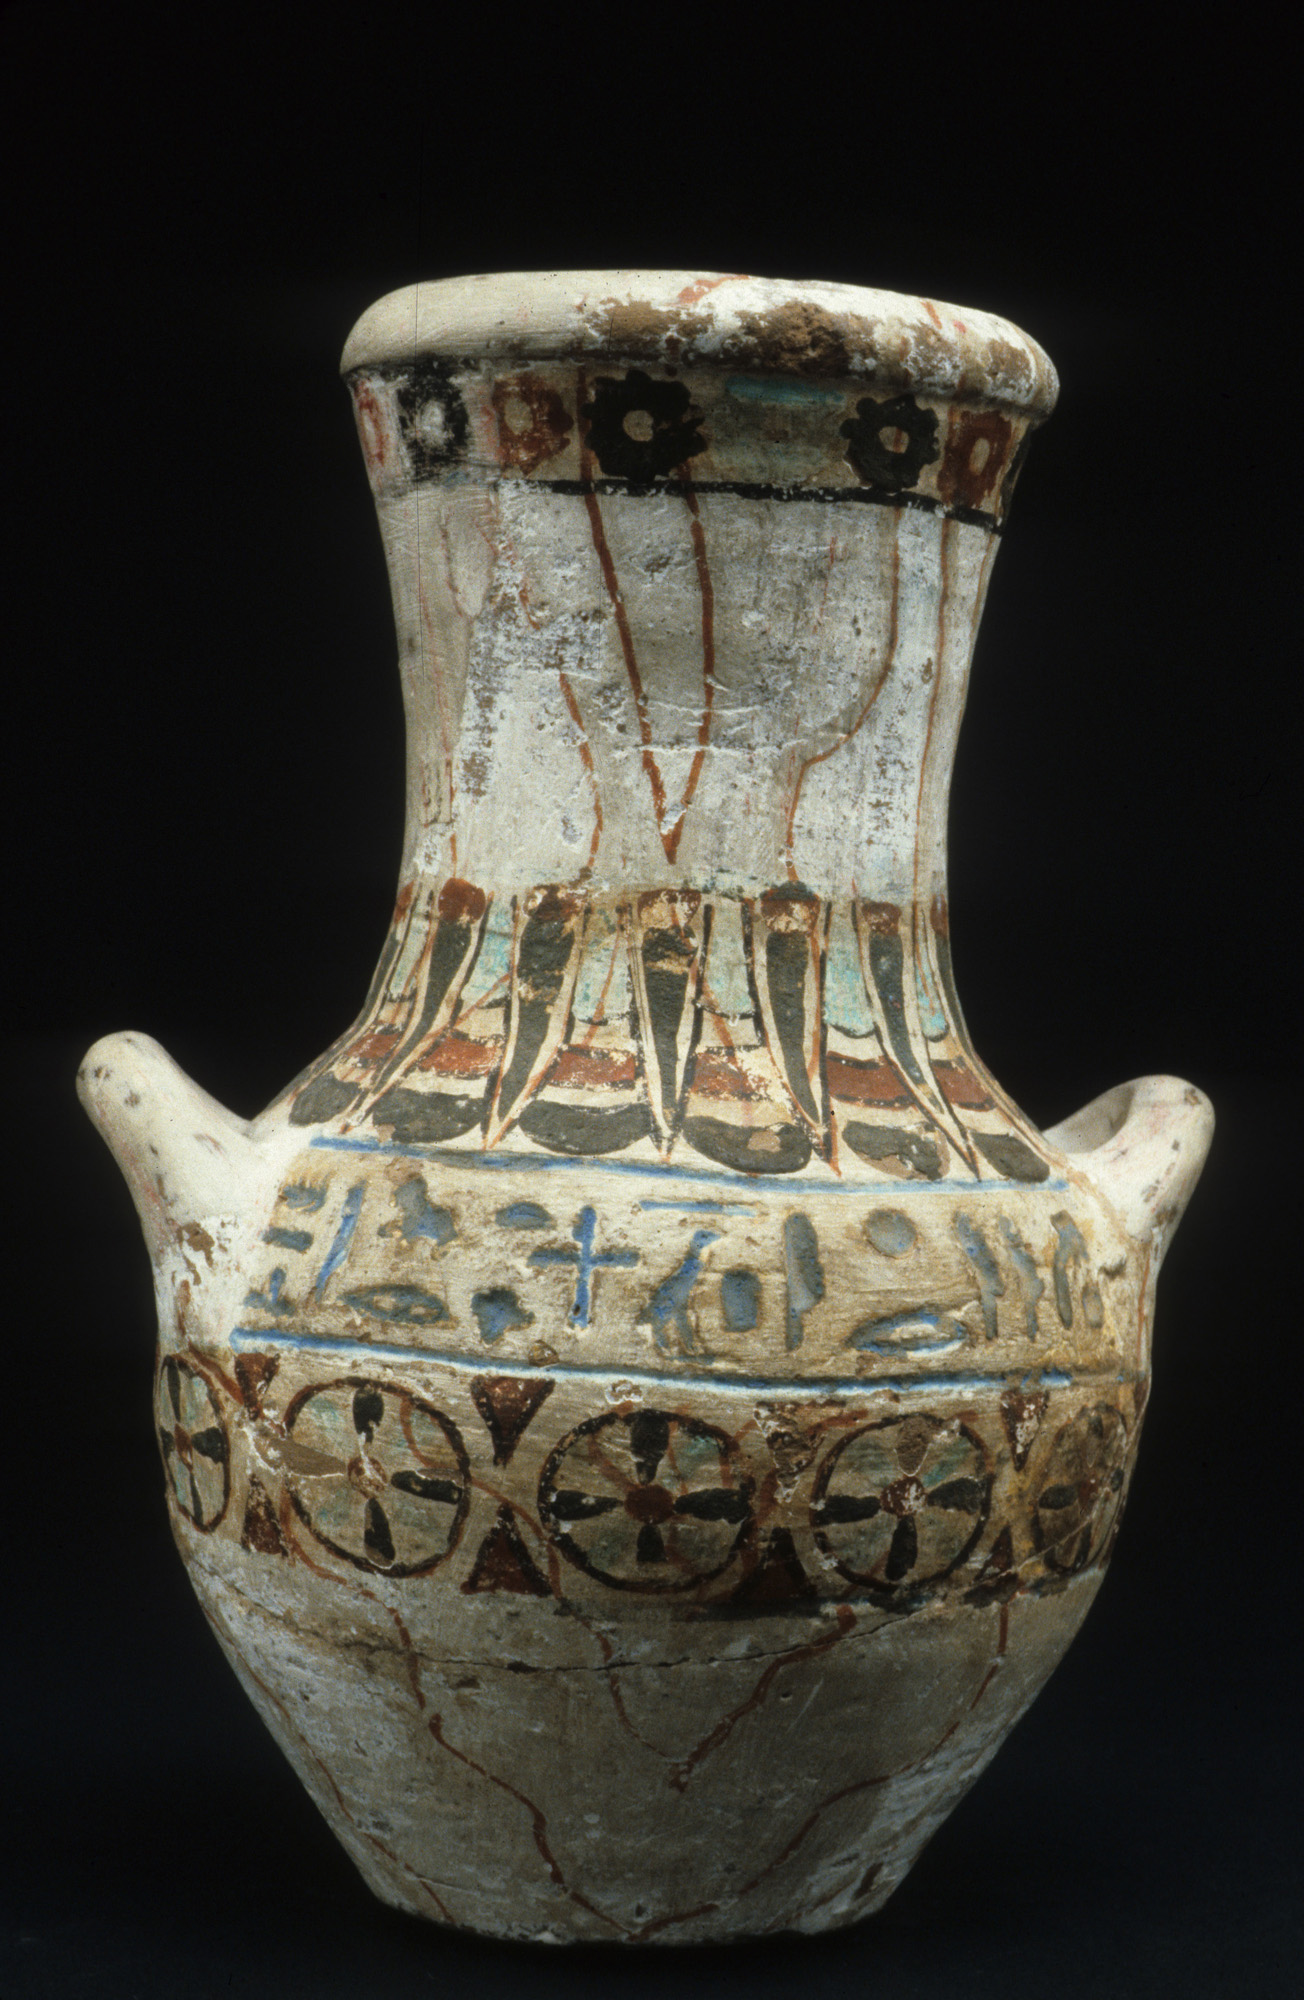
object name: vase, amenhotep, two handled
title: Two-handed pottery vase of Amenhotep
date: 1550-1295 BCE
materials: paint, pottery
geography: middle egypt